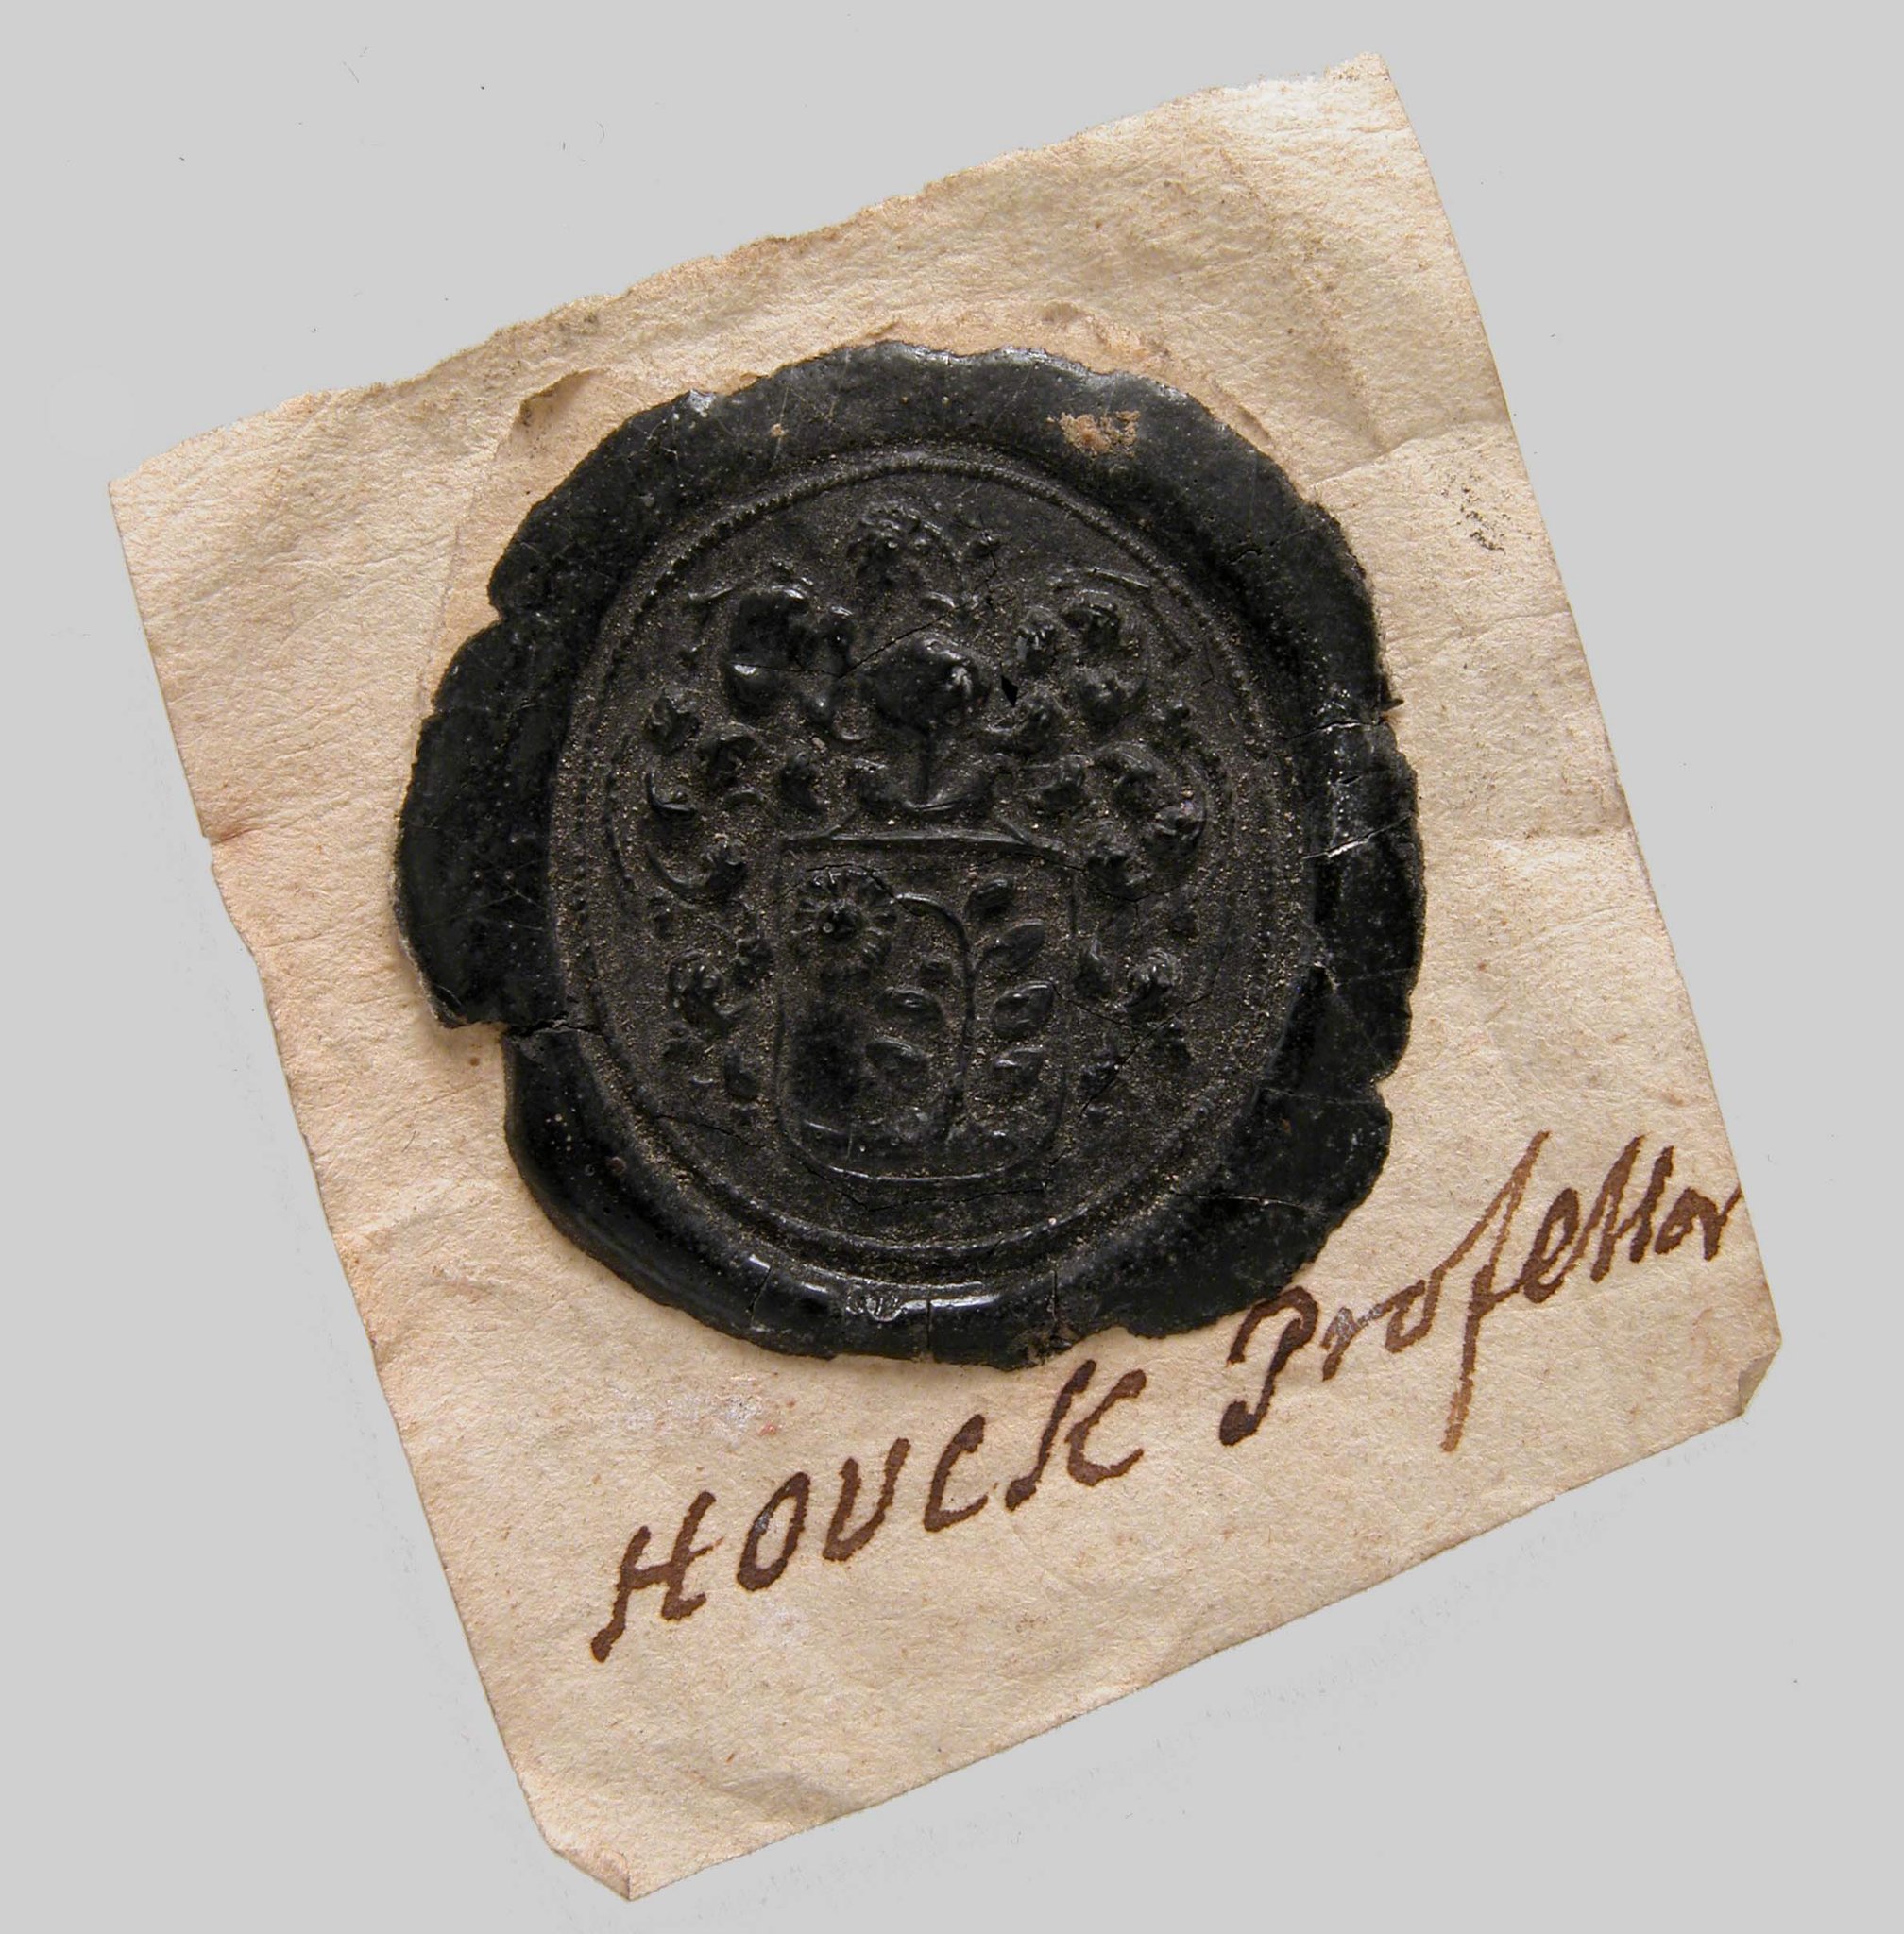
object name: seal impression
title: Seal Impression, Coat of Arms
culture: dutch or south lowlands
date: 1101-1600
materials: paper, wax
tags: coat of arms